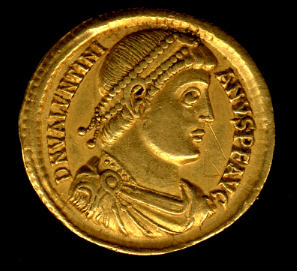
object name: solidus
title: Gold Solidus of Valentinian I (364–75)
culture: byzantine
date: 364-375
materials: gold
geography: cyzicus (now balkiz, turkey)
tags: profiles